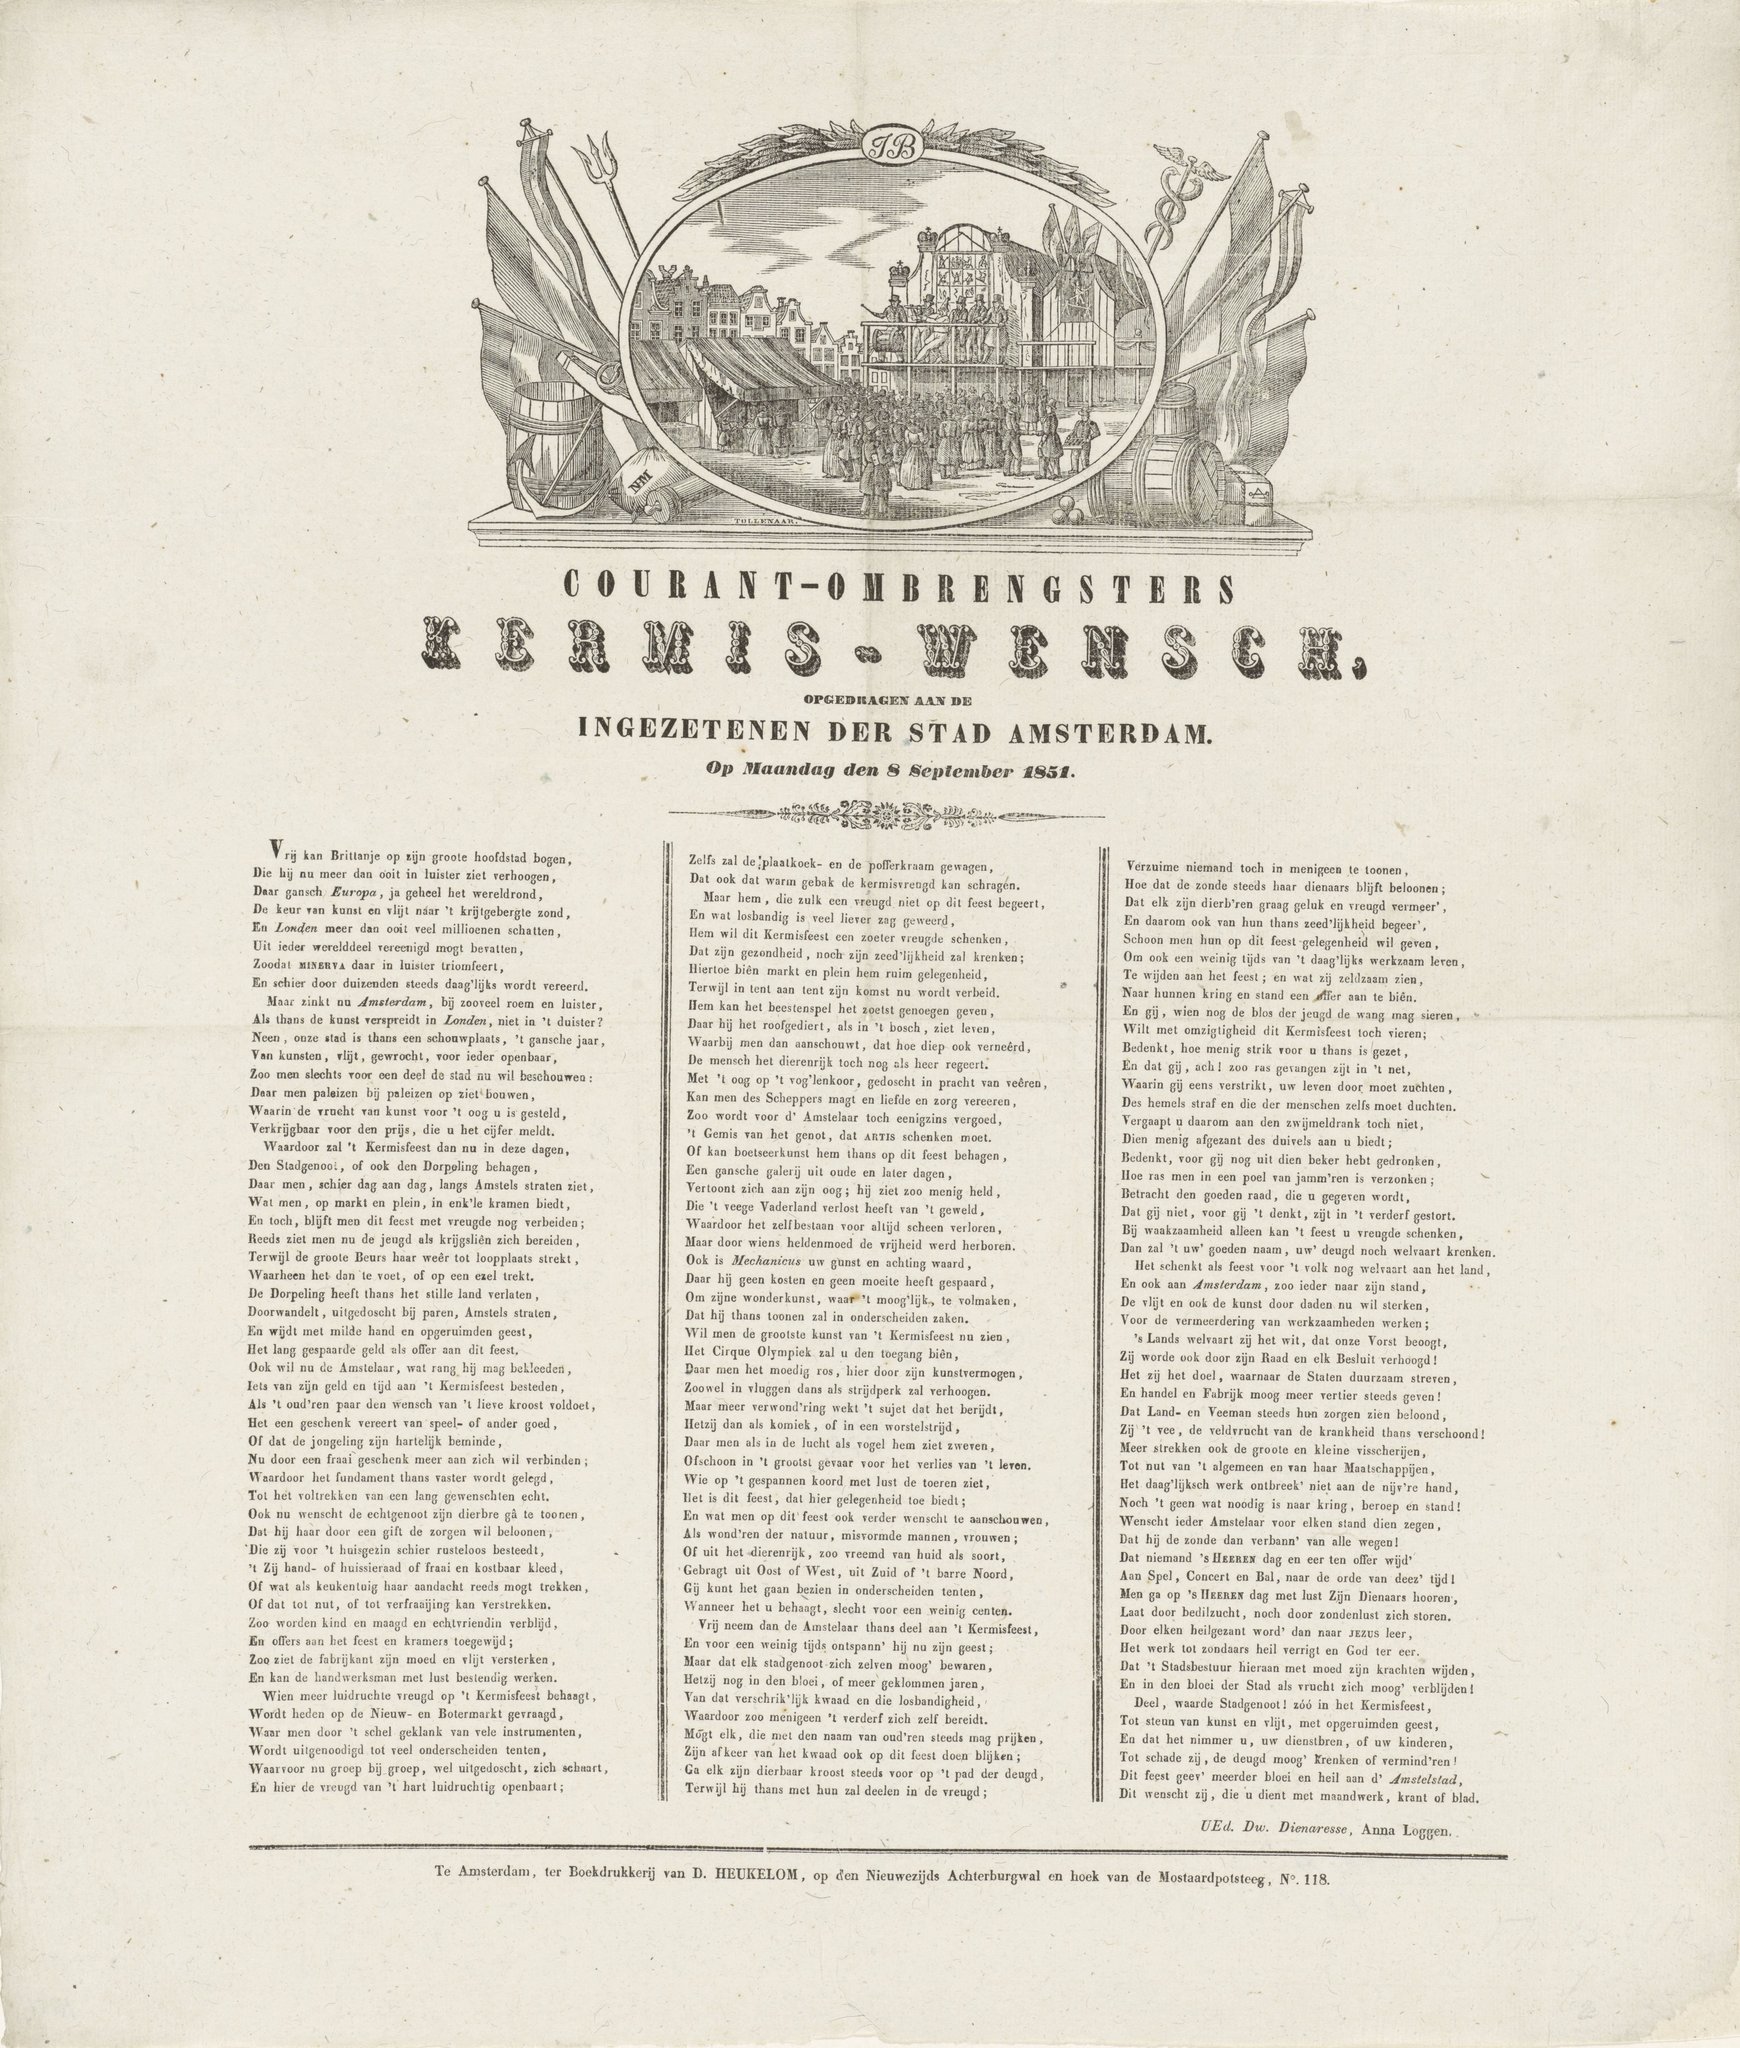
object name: print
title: Courant-Ombrengsters Kermis-Wensch (...) 1851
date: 1851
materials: paper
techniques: letterpress printing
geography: amsterdam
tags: pleasure fair and circus, amsterdam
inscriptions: collector's mark: Lugt 2228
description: Kermisprent namens de ombrengsters van couranten (krantenbezorgers) te Amsterdam, 8 september 1851. Bovenaan een medaillon met een gezicht op de kermis op de Botermarkt. Onderaan een gedicht in drie kolommen. Van de courantombrengster: Anna Loggen.